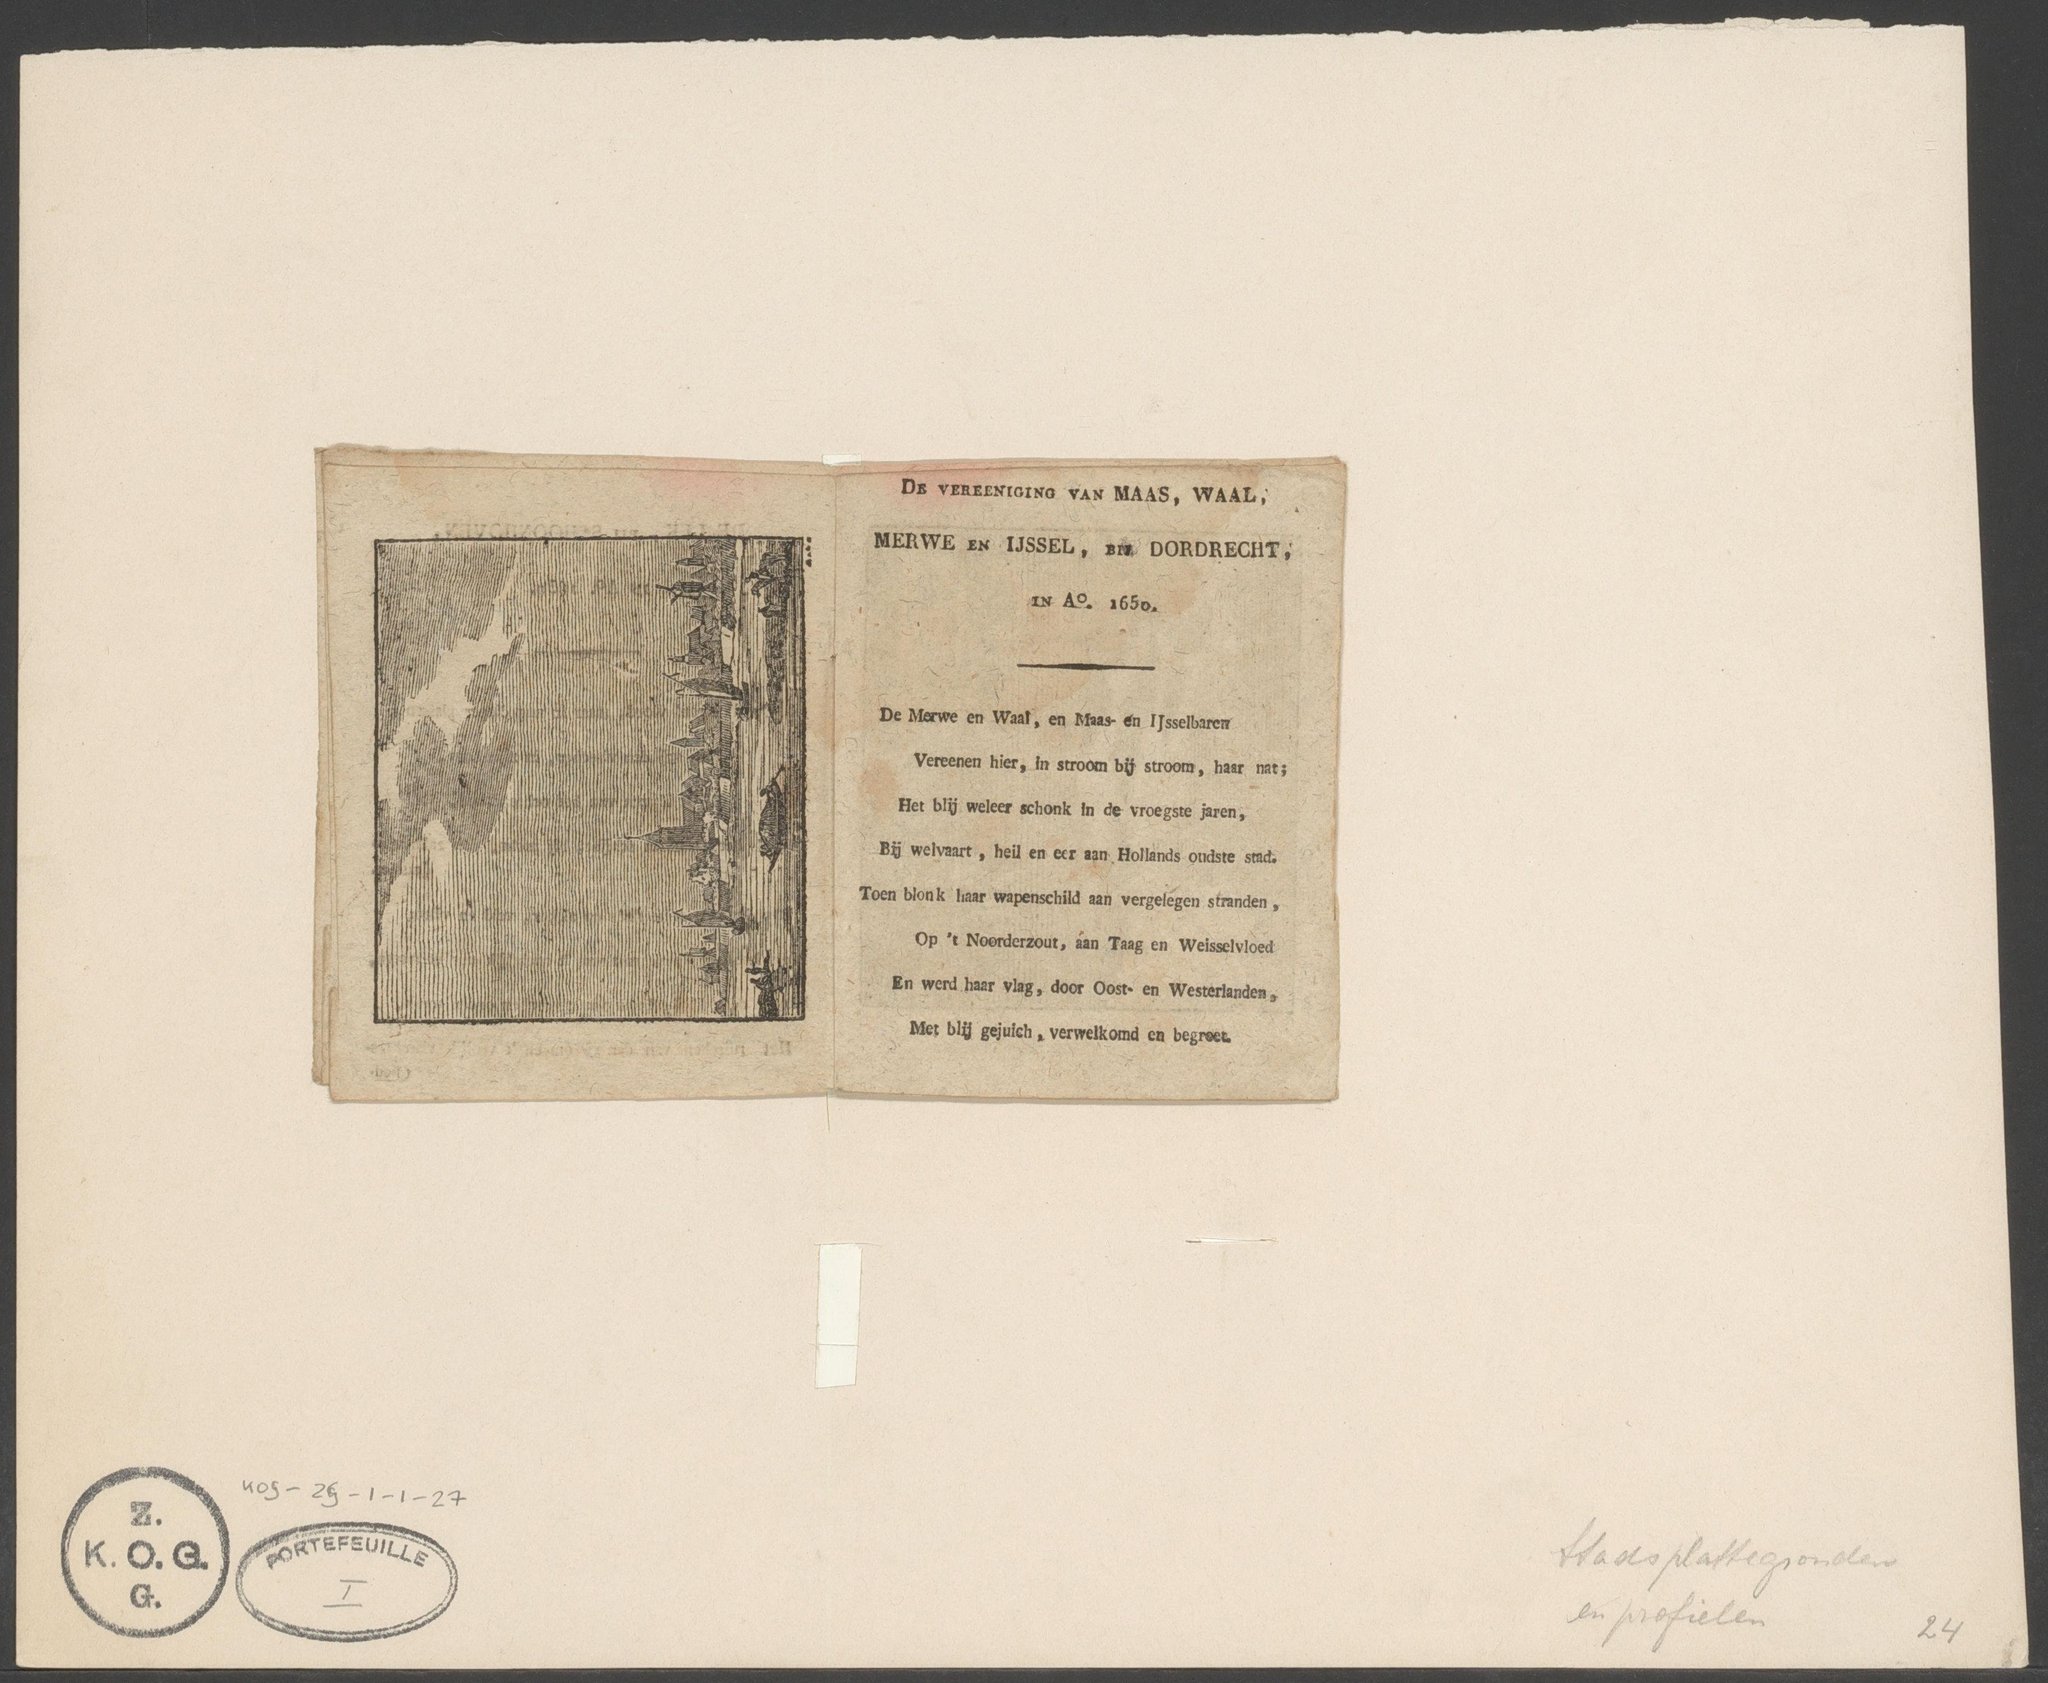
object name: print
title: Prentverbeeldingen van een zevental Gezigten op Rivieren van ons Vaderland; met toepasselijke Bijschriften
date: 1837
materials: paper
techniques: letterpress printing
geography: netherlands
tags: river, dordrecht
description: Rivierlandschap bij Dordrecht, met achtregelig vers. Onderdeel van een gevouwen boekje met zeven gezichten met Nederlandse rivierlandschappen met bijpassende verzen met jaartallen. Onderwerpsrubrieken binnen de Atlas Zeden en Gewoonten: topografie.